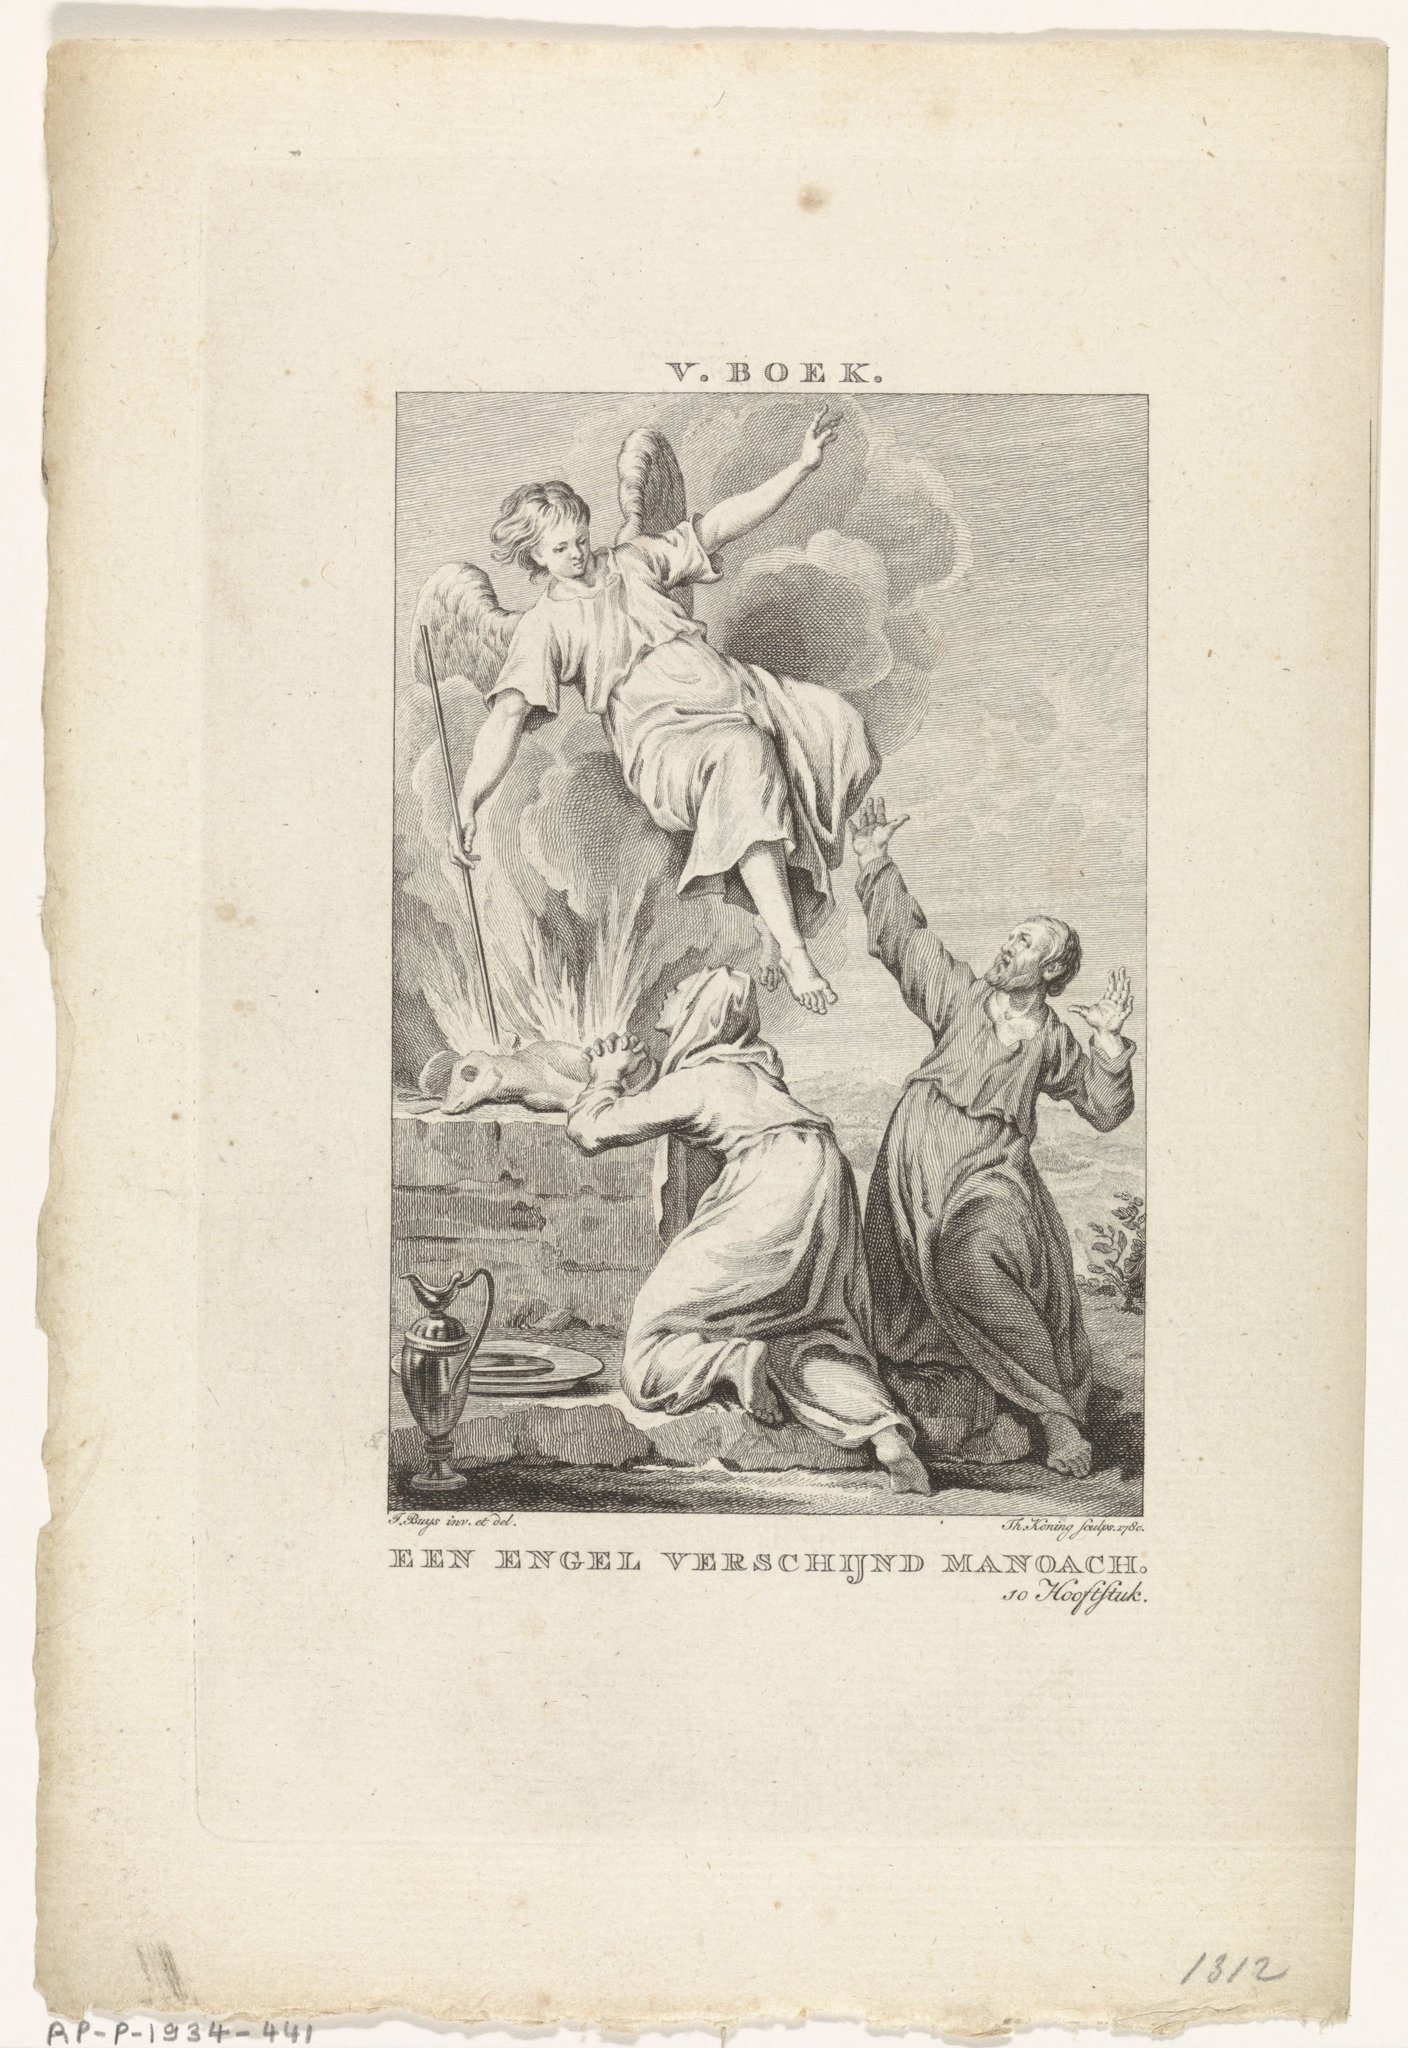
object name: book illustration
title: Een engel verschijnd Manoach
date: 1780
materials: paper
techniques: engraving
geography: amsterdam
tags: manoah's sacrifice; the angel ascends in the flames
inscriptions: collector's mark: Lugt 2228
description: In een landschap zitten Manoach en zijn vrouw bij een altaar waar zij zojuist een offer hebben gebracht. Aan hen verschijnt een engel, die in de vlam van hun offer opstijgt. Deze prent is een illustratie bij het tiende hoofdstuk van het vijfde boek van 'Alle de werken van Flavius Josephus'.